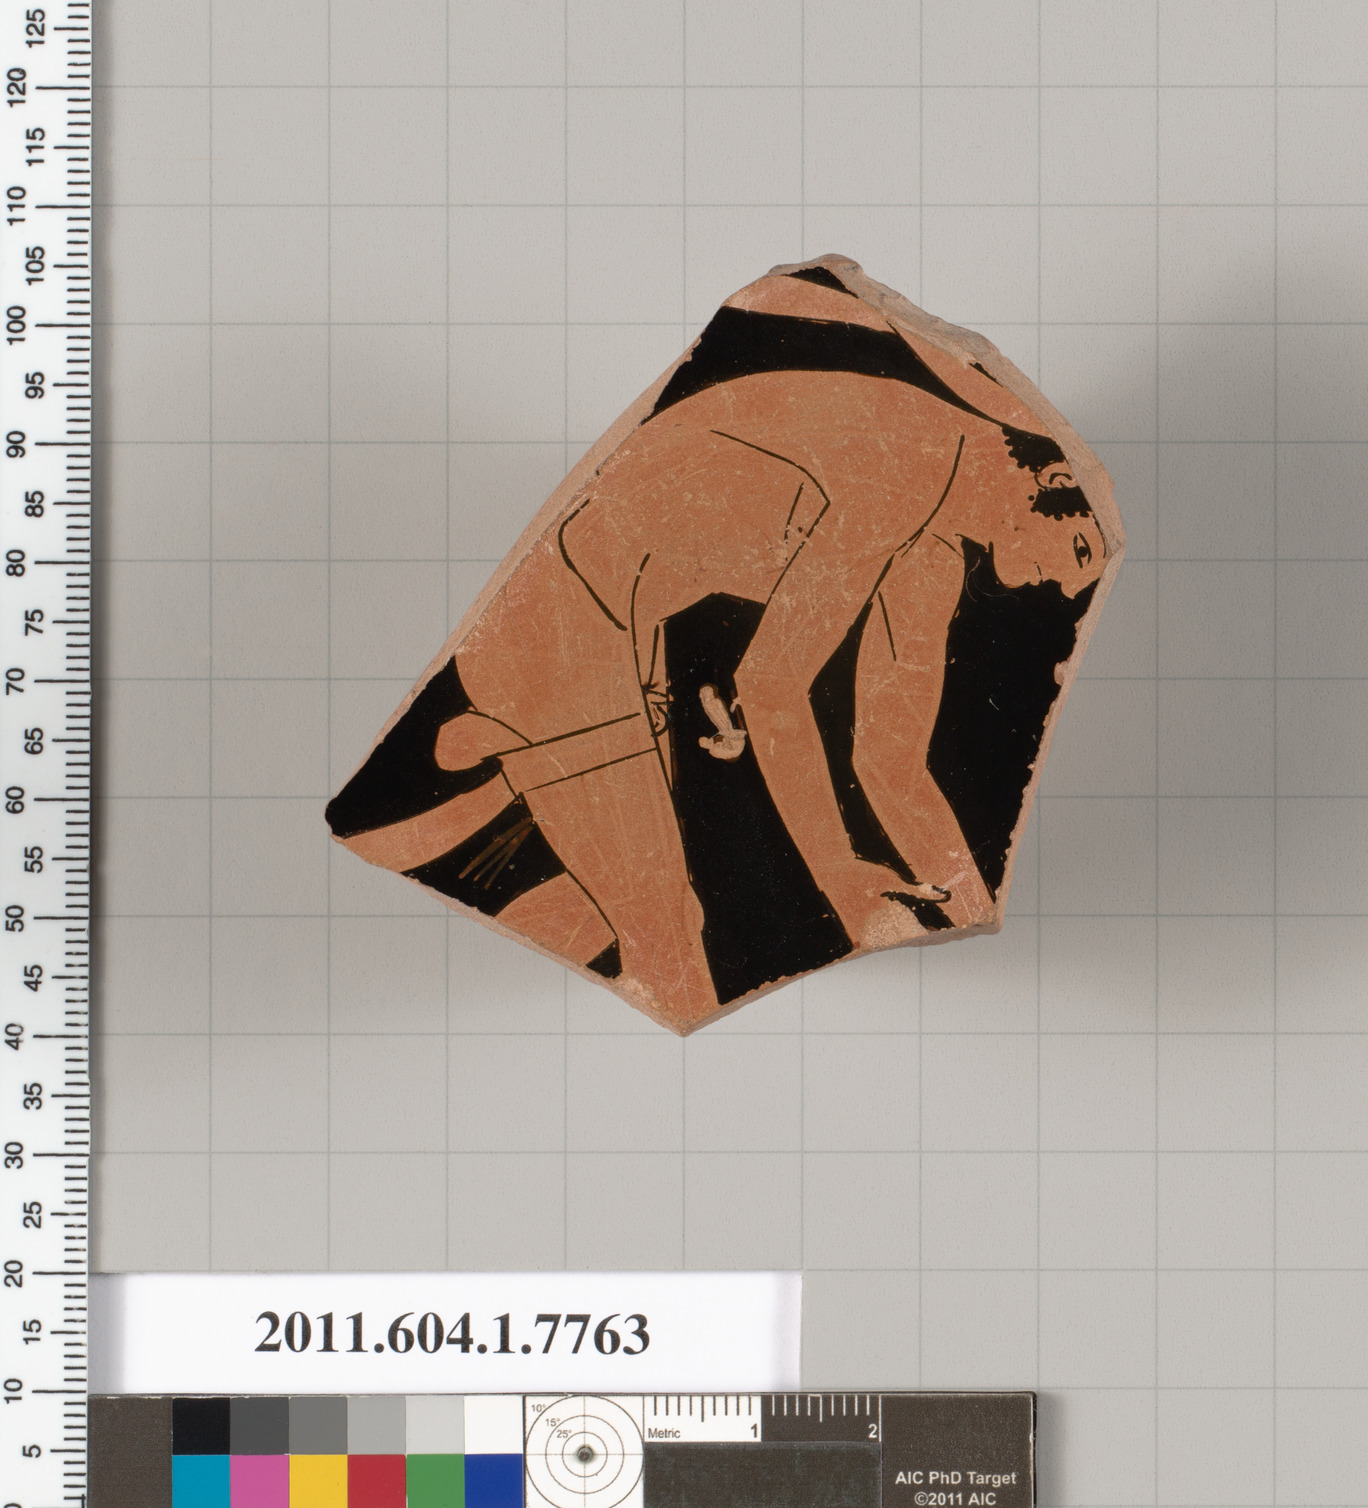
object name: kylix fragment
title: Terracotta fragment of a kylix (drinking cup)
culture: greek, attic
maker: villa giulia painter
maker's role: artist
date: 460-450 BCE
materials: terracotta